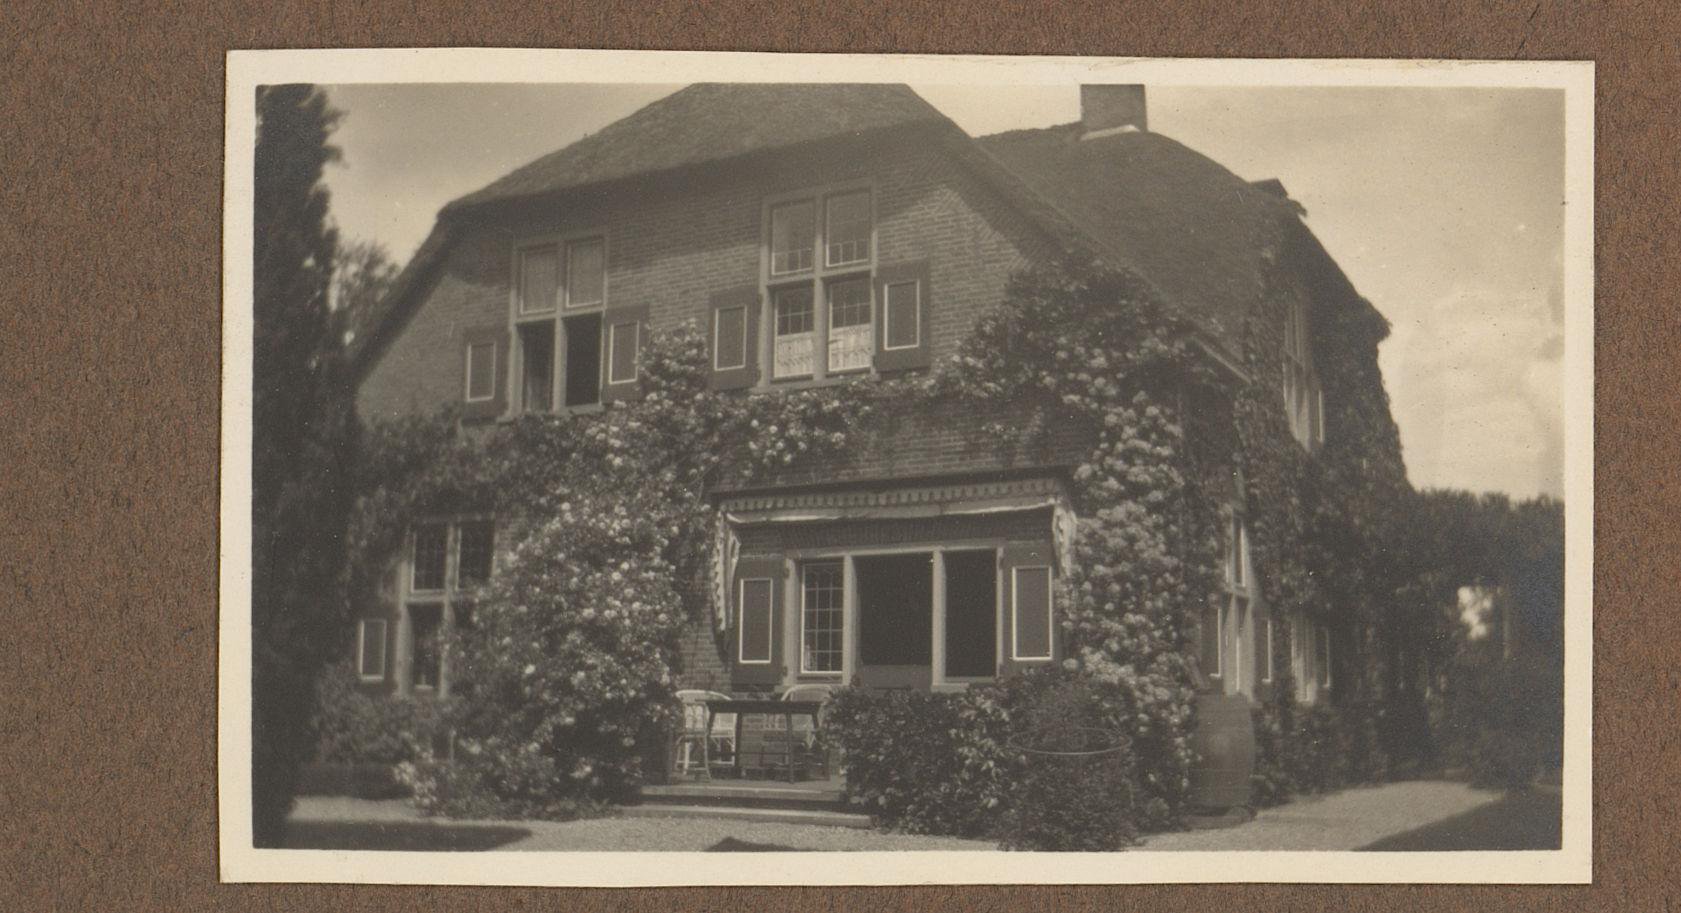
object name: photograph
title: Villa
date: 1900-1920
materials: photographic support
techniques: photography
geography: netherlands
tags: netherlands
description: Foto op bruin albumblad 57 van familiealbum van Alphons Diepenbrock.